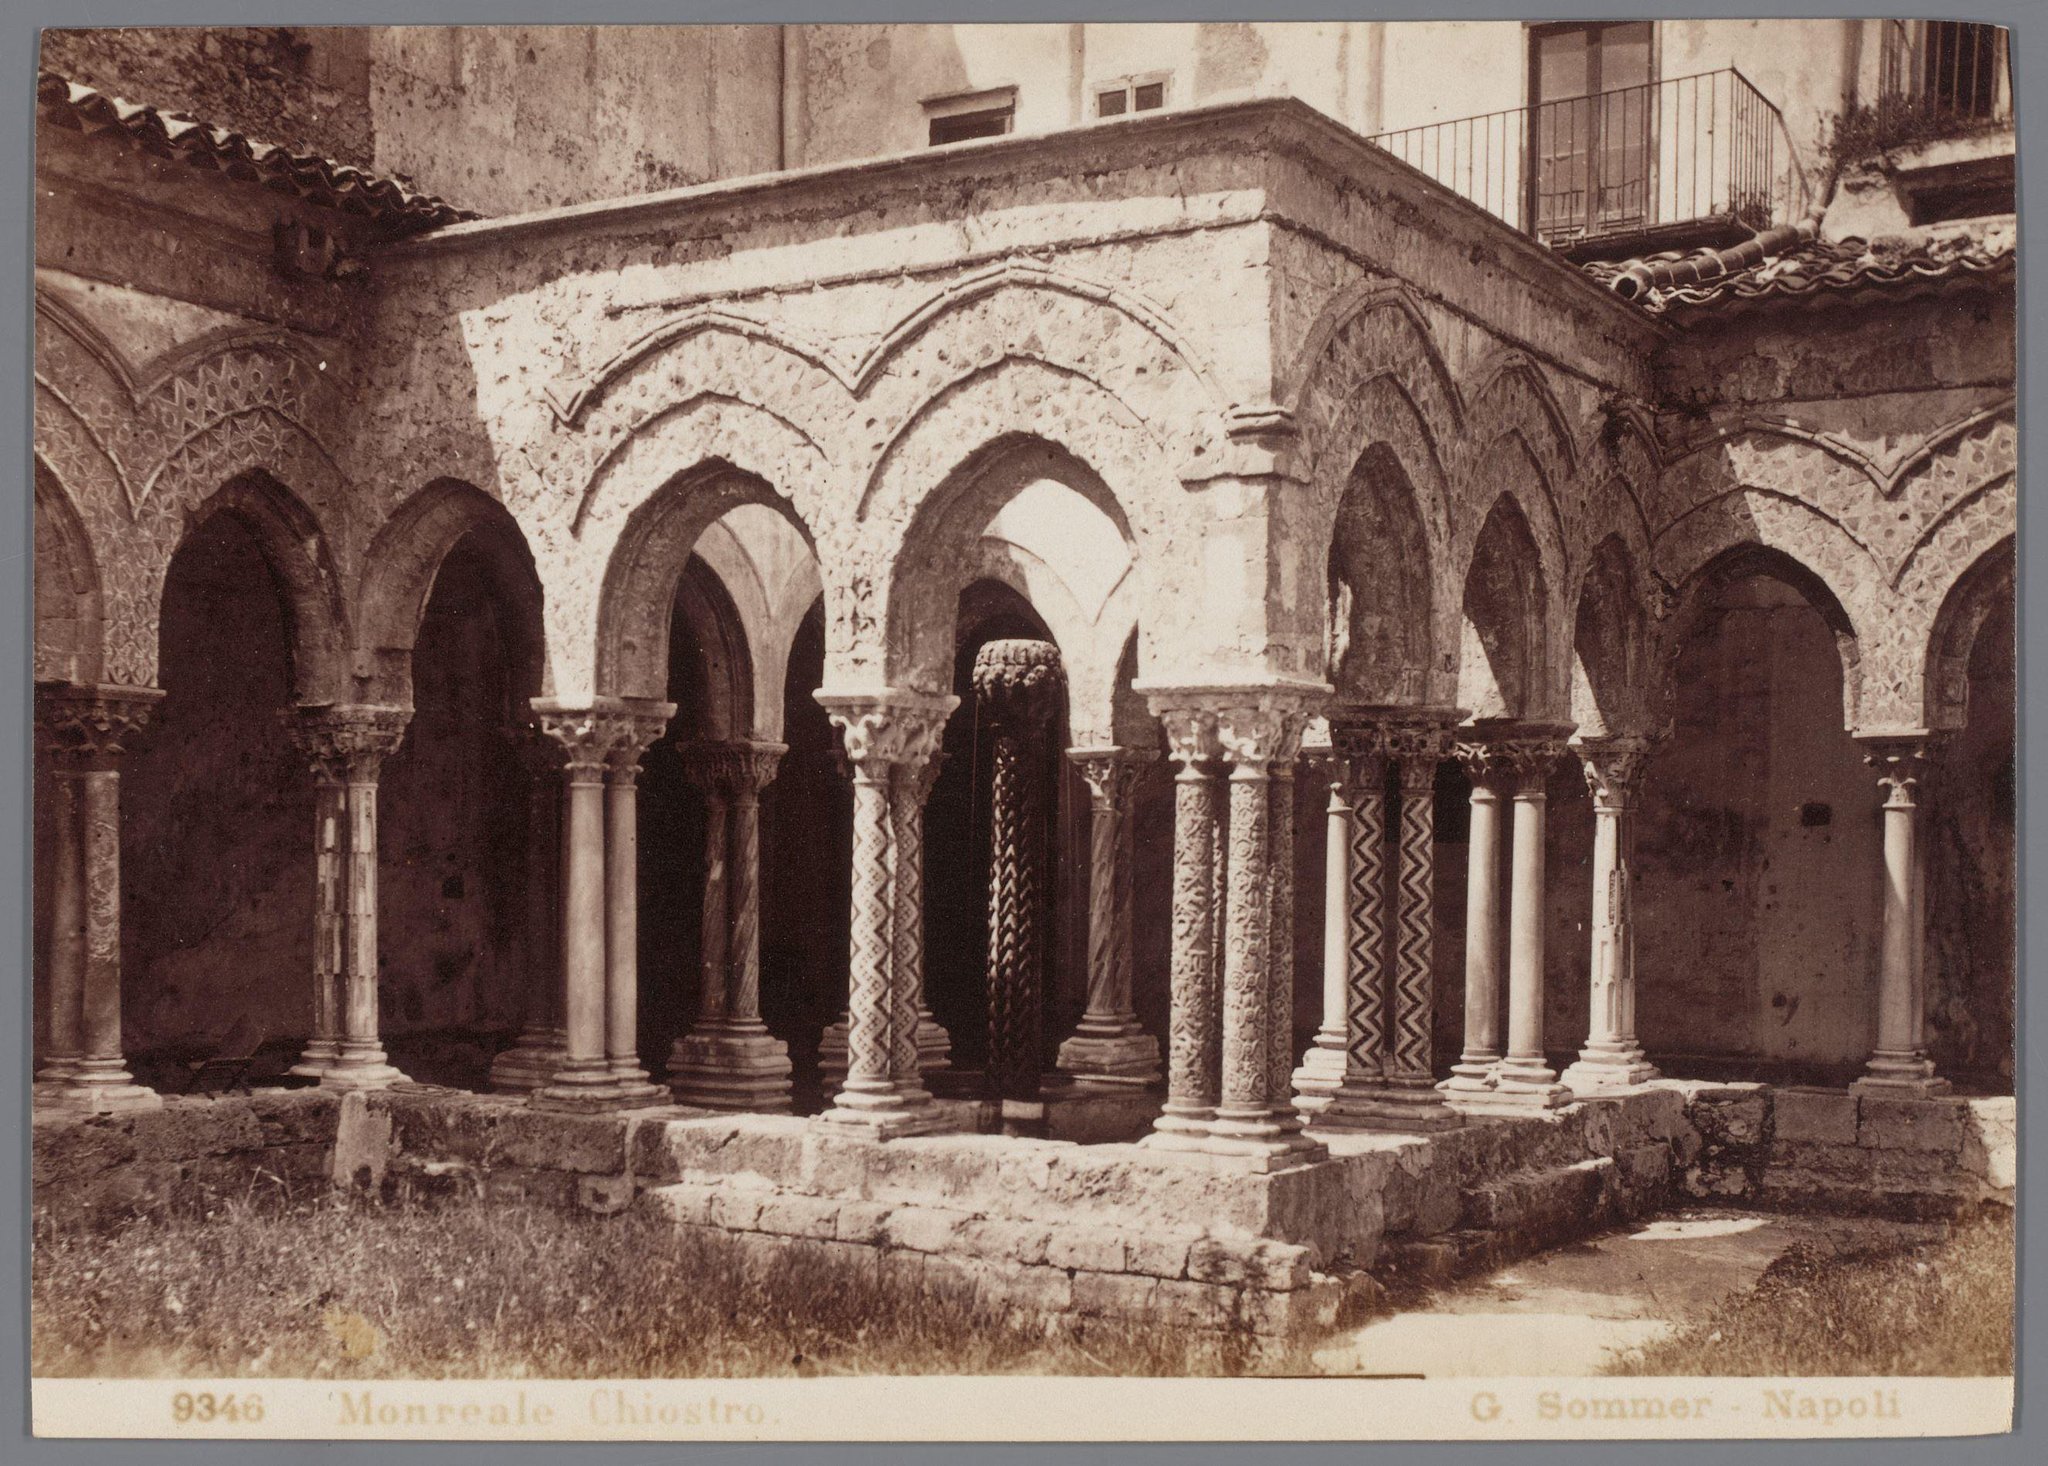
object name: photograph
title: Monreale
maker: giorgio sommer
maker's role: fotograaf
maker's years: 1834-1914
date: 1870-1890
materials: paper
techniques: albumen print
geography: monreale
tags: column, pillar ~ architecture, gallery (spacious corridor), parts of church exterior and annexes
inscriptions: collector's mark: ‘VOSMAER’, number: ‘9346’